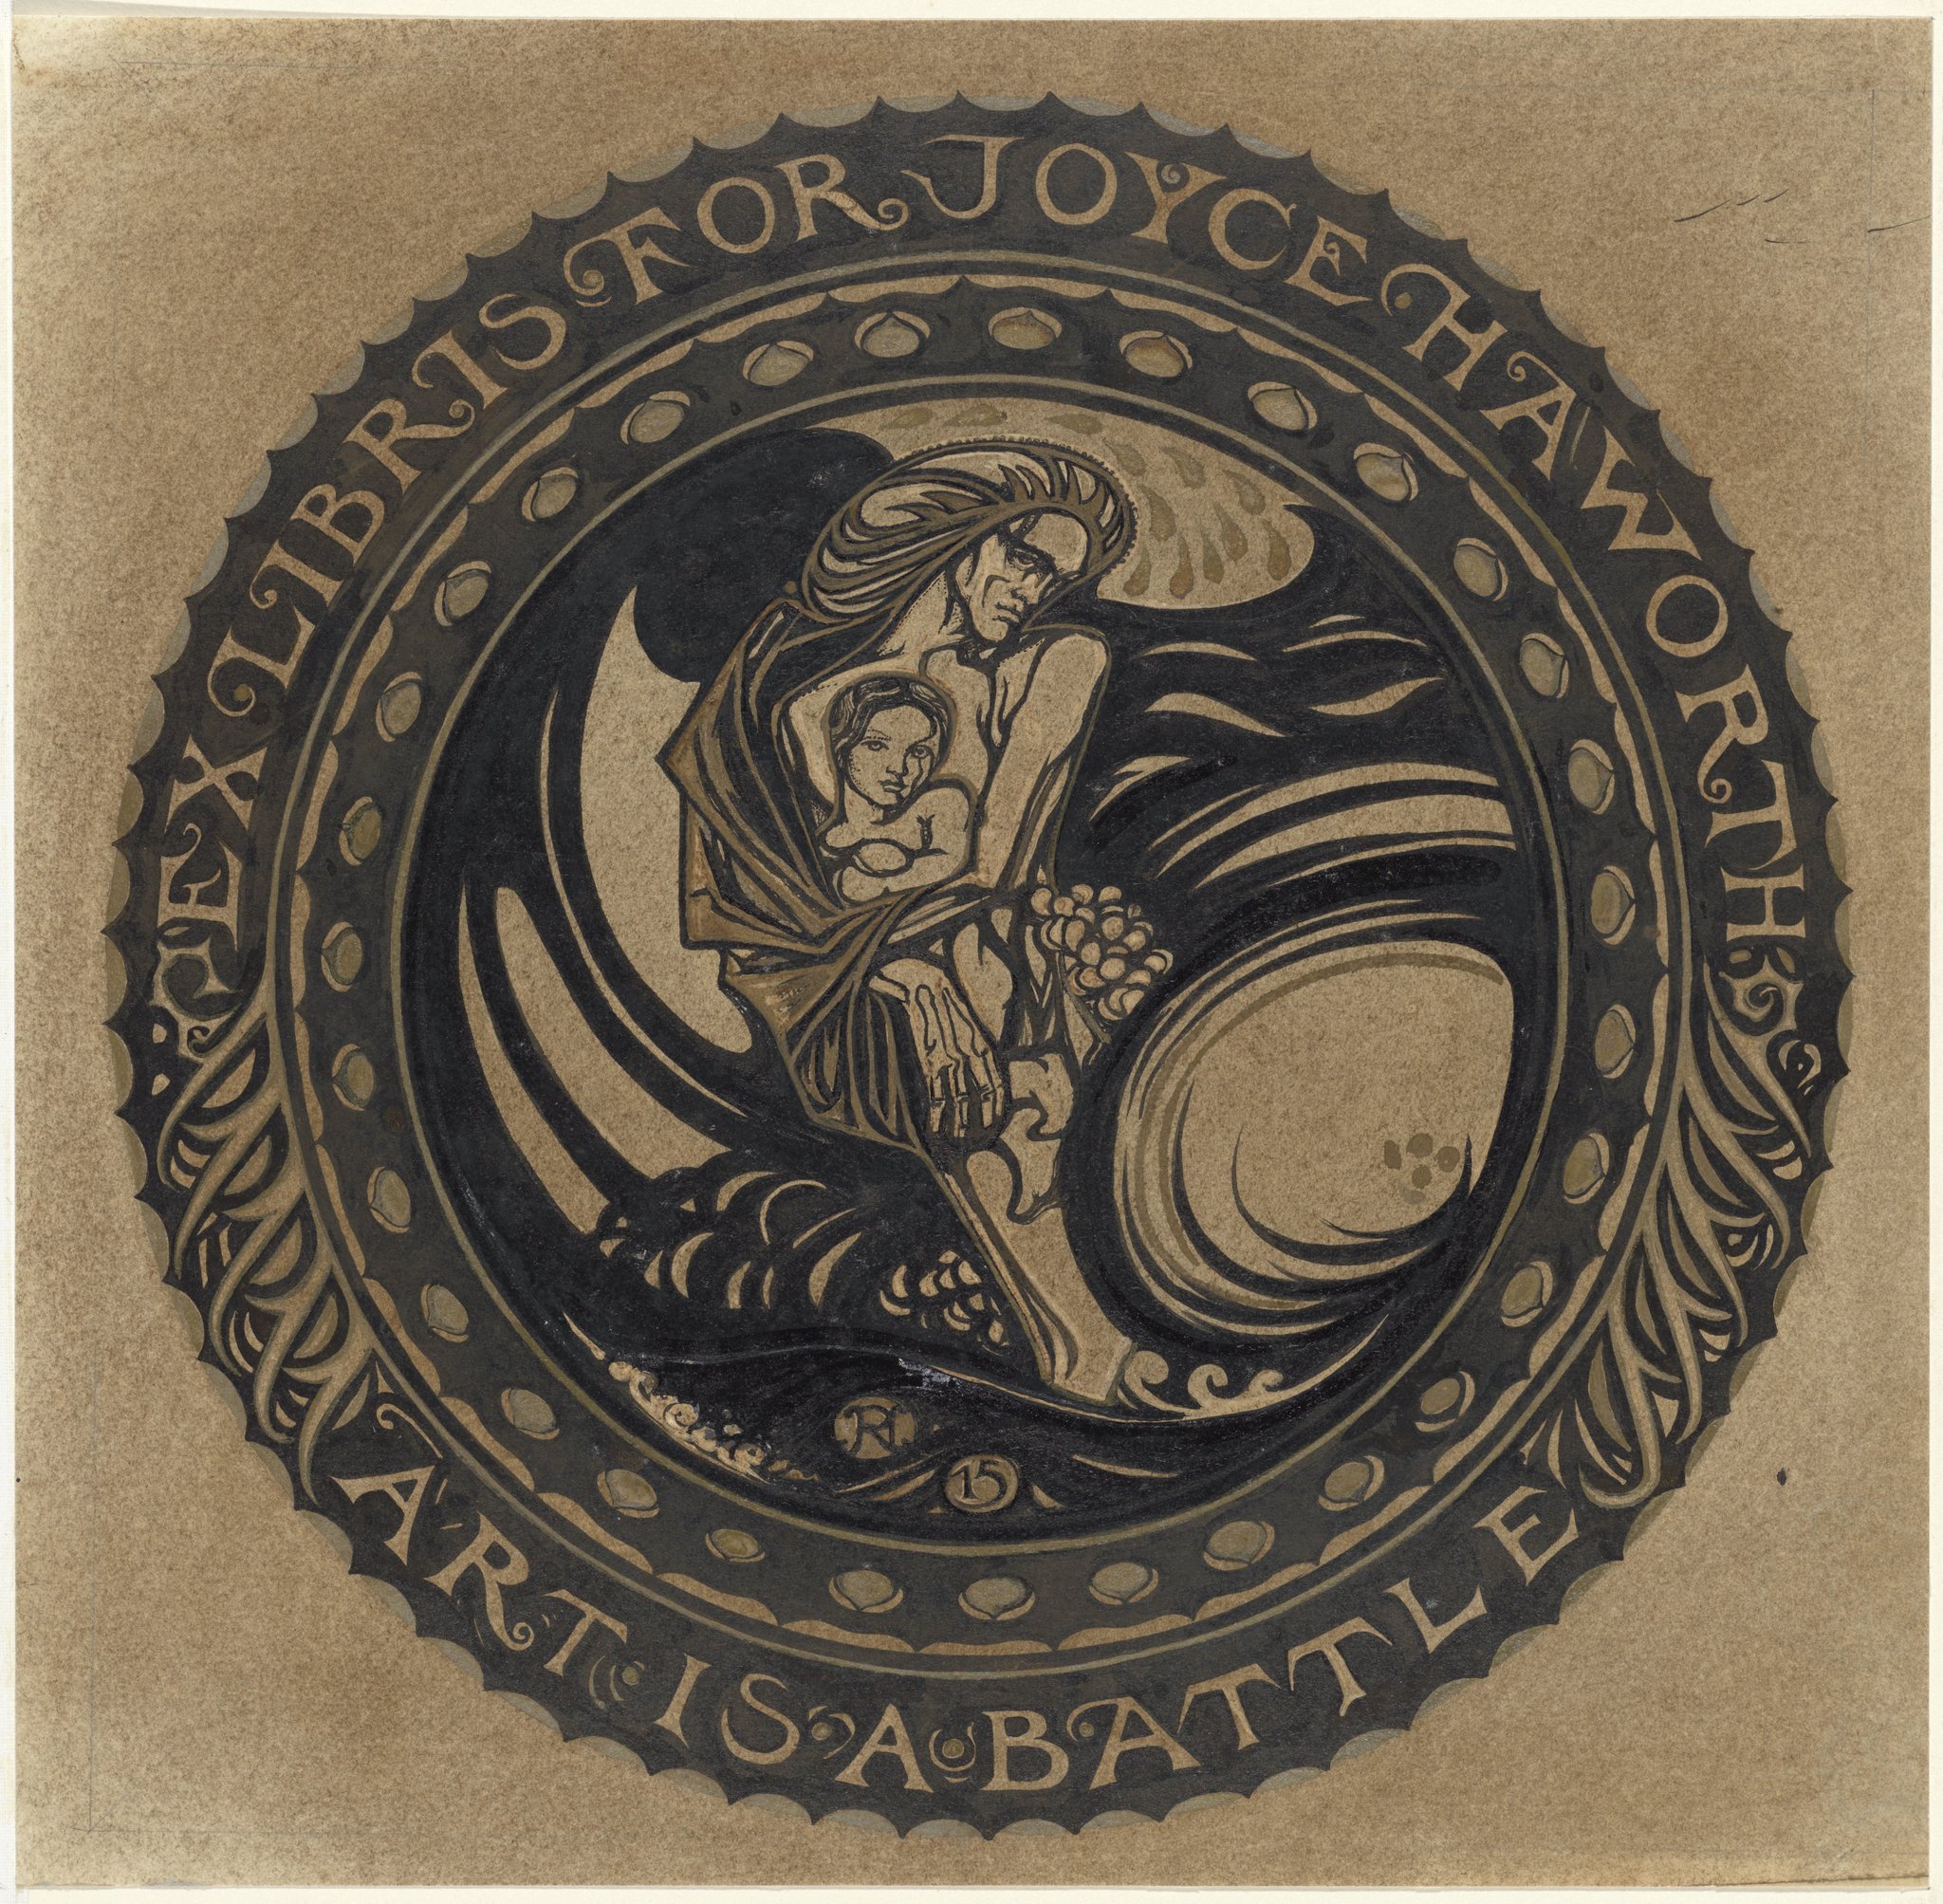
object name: design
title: Ontwerp voor ex libris voor Joyce Haworth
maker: richard nicolaüs roland holst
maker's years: 1868-1938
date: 1915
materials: paint, paper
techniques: brush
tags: ex-libris